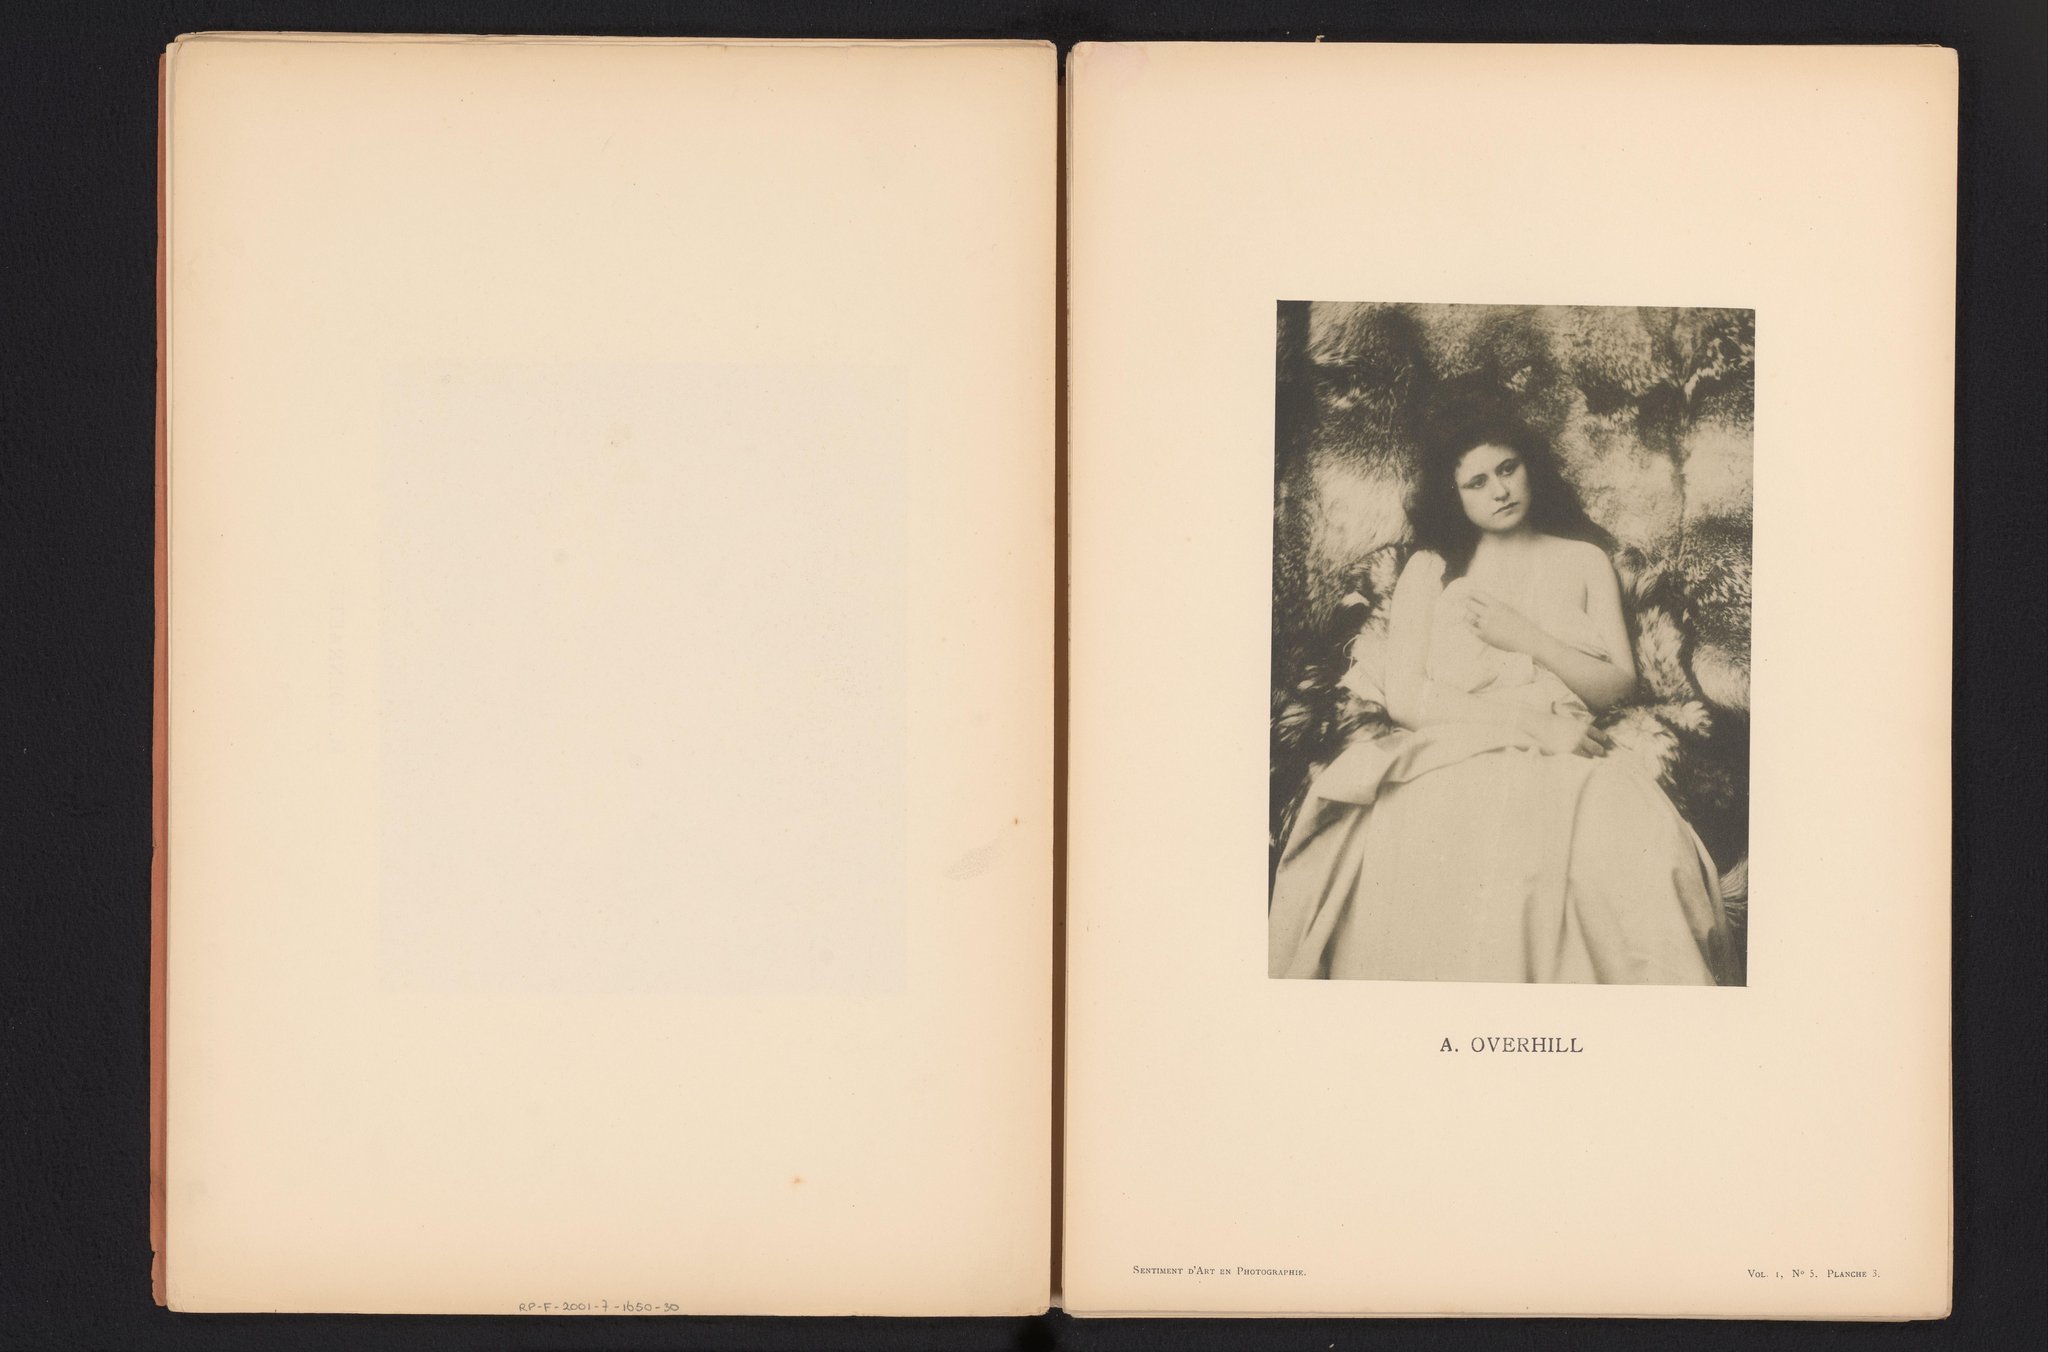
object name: photomechanical print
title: Sentiment d'Art en Photographie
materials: paper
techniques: photograph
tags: historical persons - bb - woman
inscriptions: number: ‘Vol. 1, No 5, Planche 3.’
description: Deze prent maakt deel uit van 8 omslagen met 22 tekstbladen en 89 prenten op losse bladen in en tussen de omslagen.